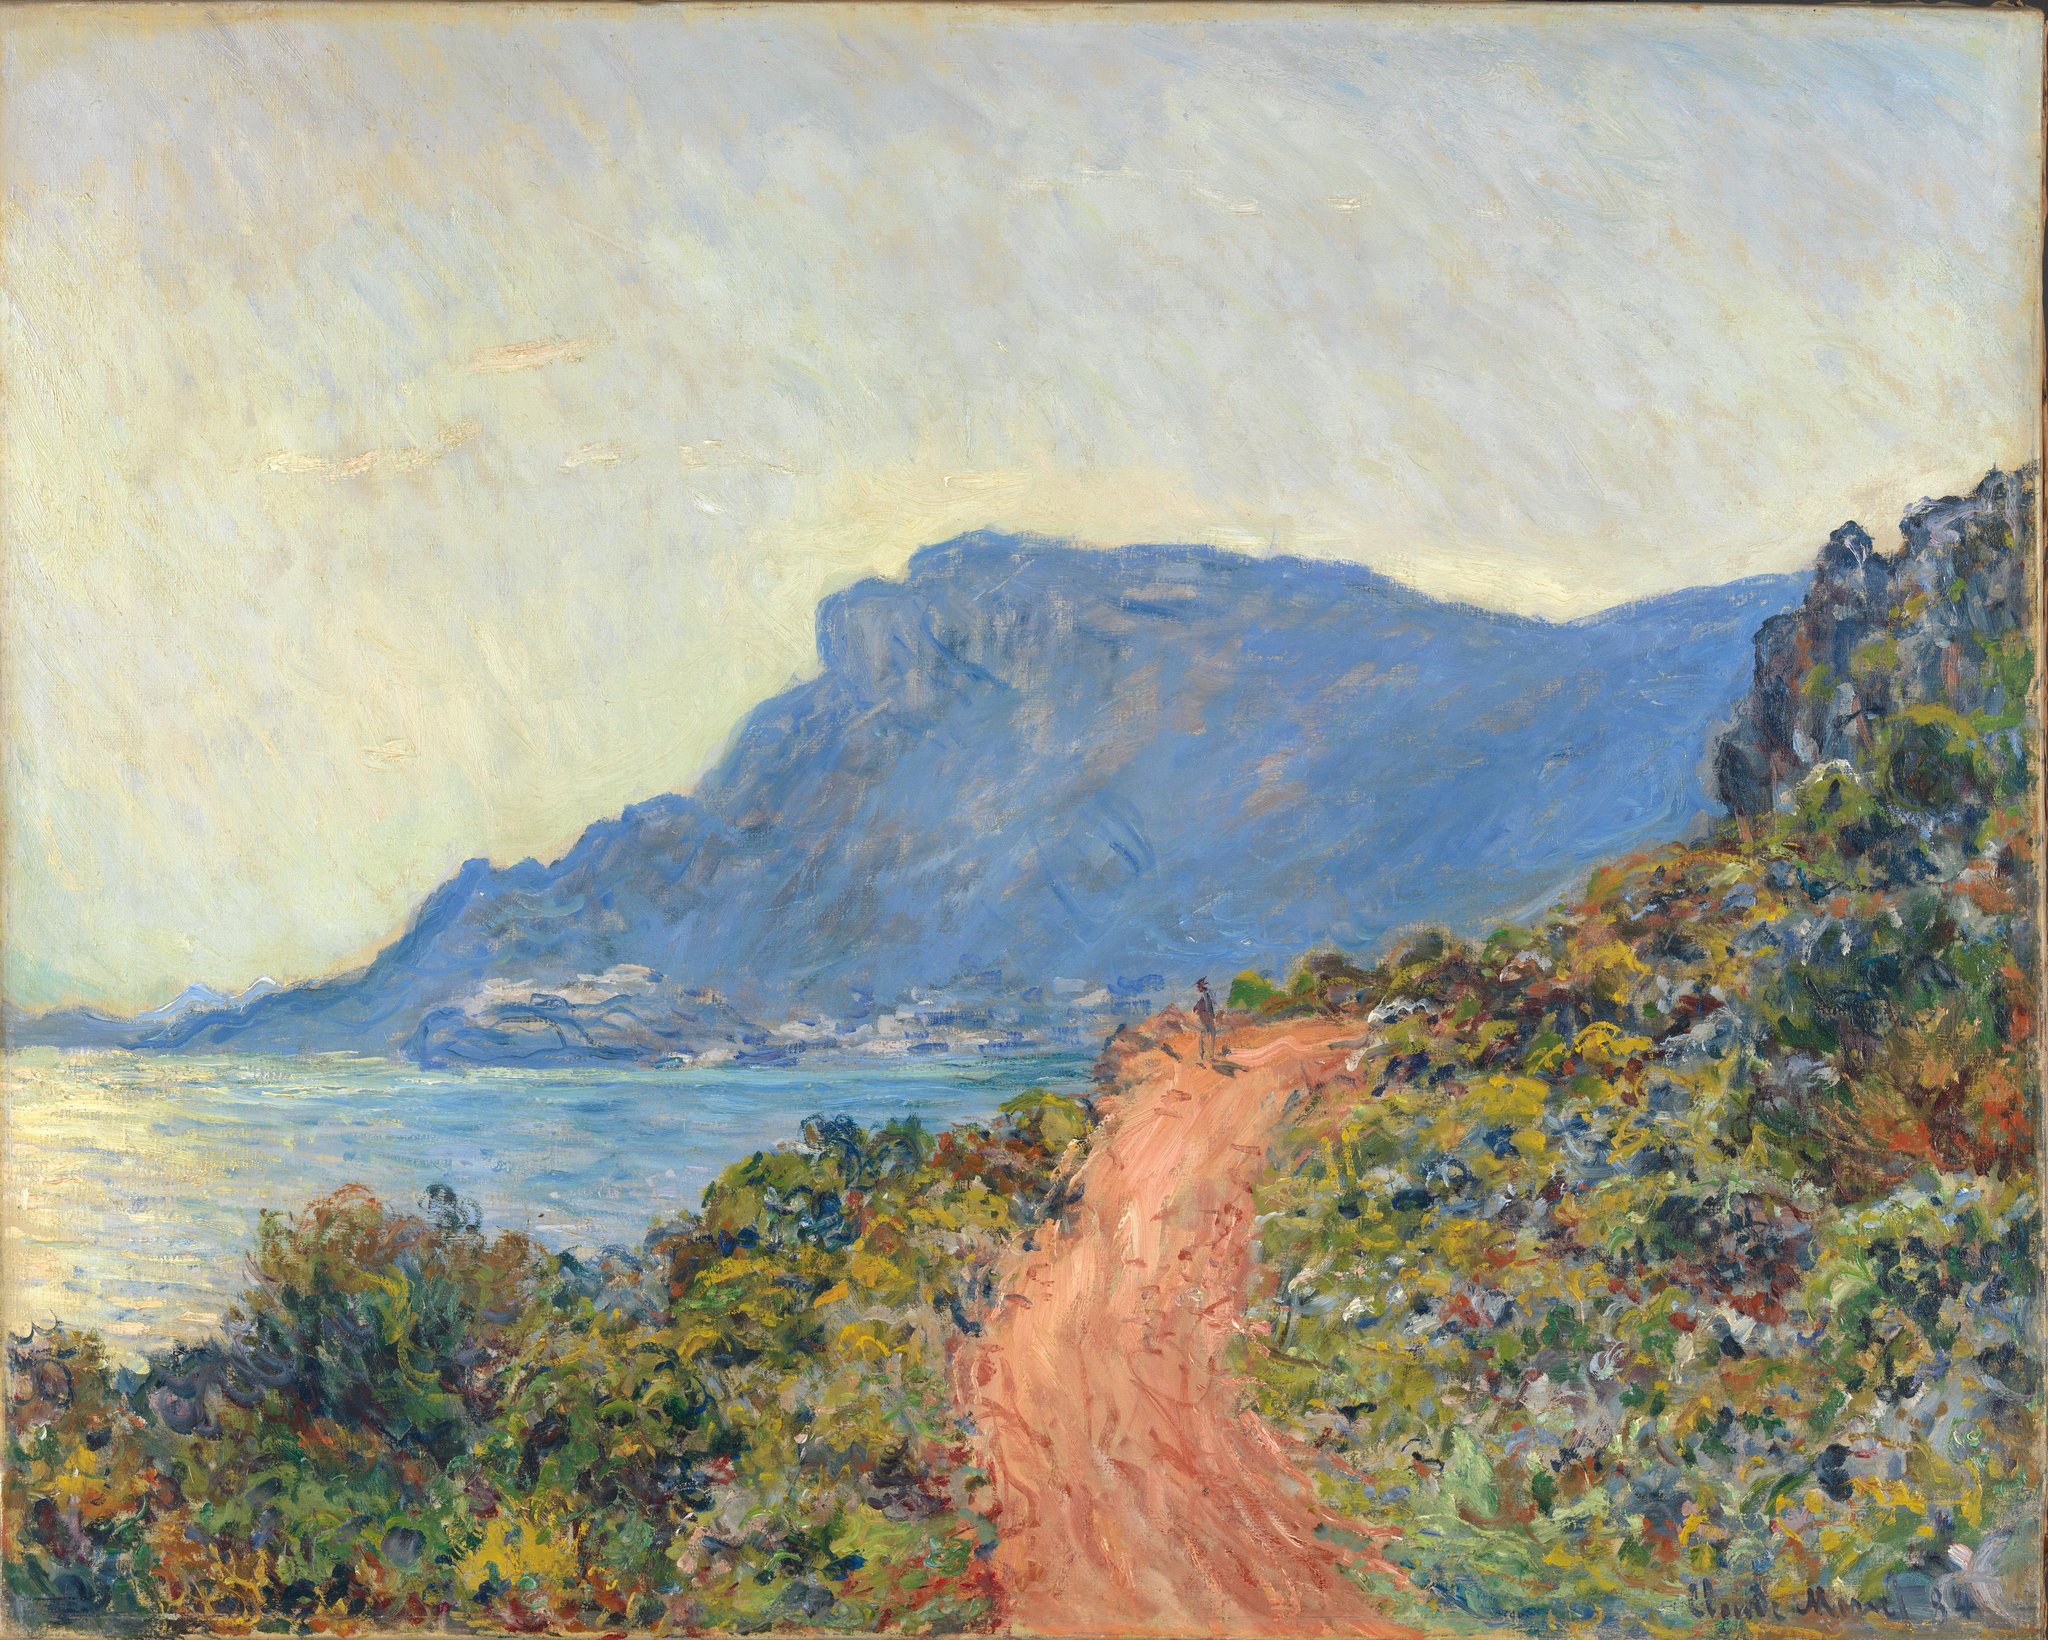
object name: painting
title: La Corniche near Monaco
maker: claude monet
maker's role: painter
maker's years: 1840-1926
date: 1884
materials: canvas, oil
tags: road, path, coast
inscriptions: signature and date: ‘Claude Monet 84’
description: In Monet’s time La Corniche was a narrow mountain track; nowadays, it is the main road between Nice and Monaco. Here the sun is high, the lone walker’s shadow short. Monet’s colours glisten: red, green, blue – everything shimmers in the sunlight. The painting was given to the Rijksmuseum already in 1900, when Monet’s work was still entirely unknown in the Netherlands.